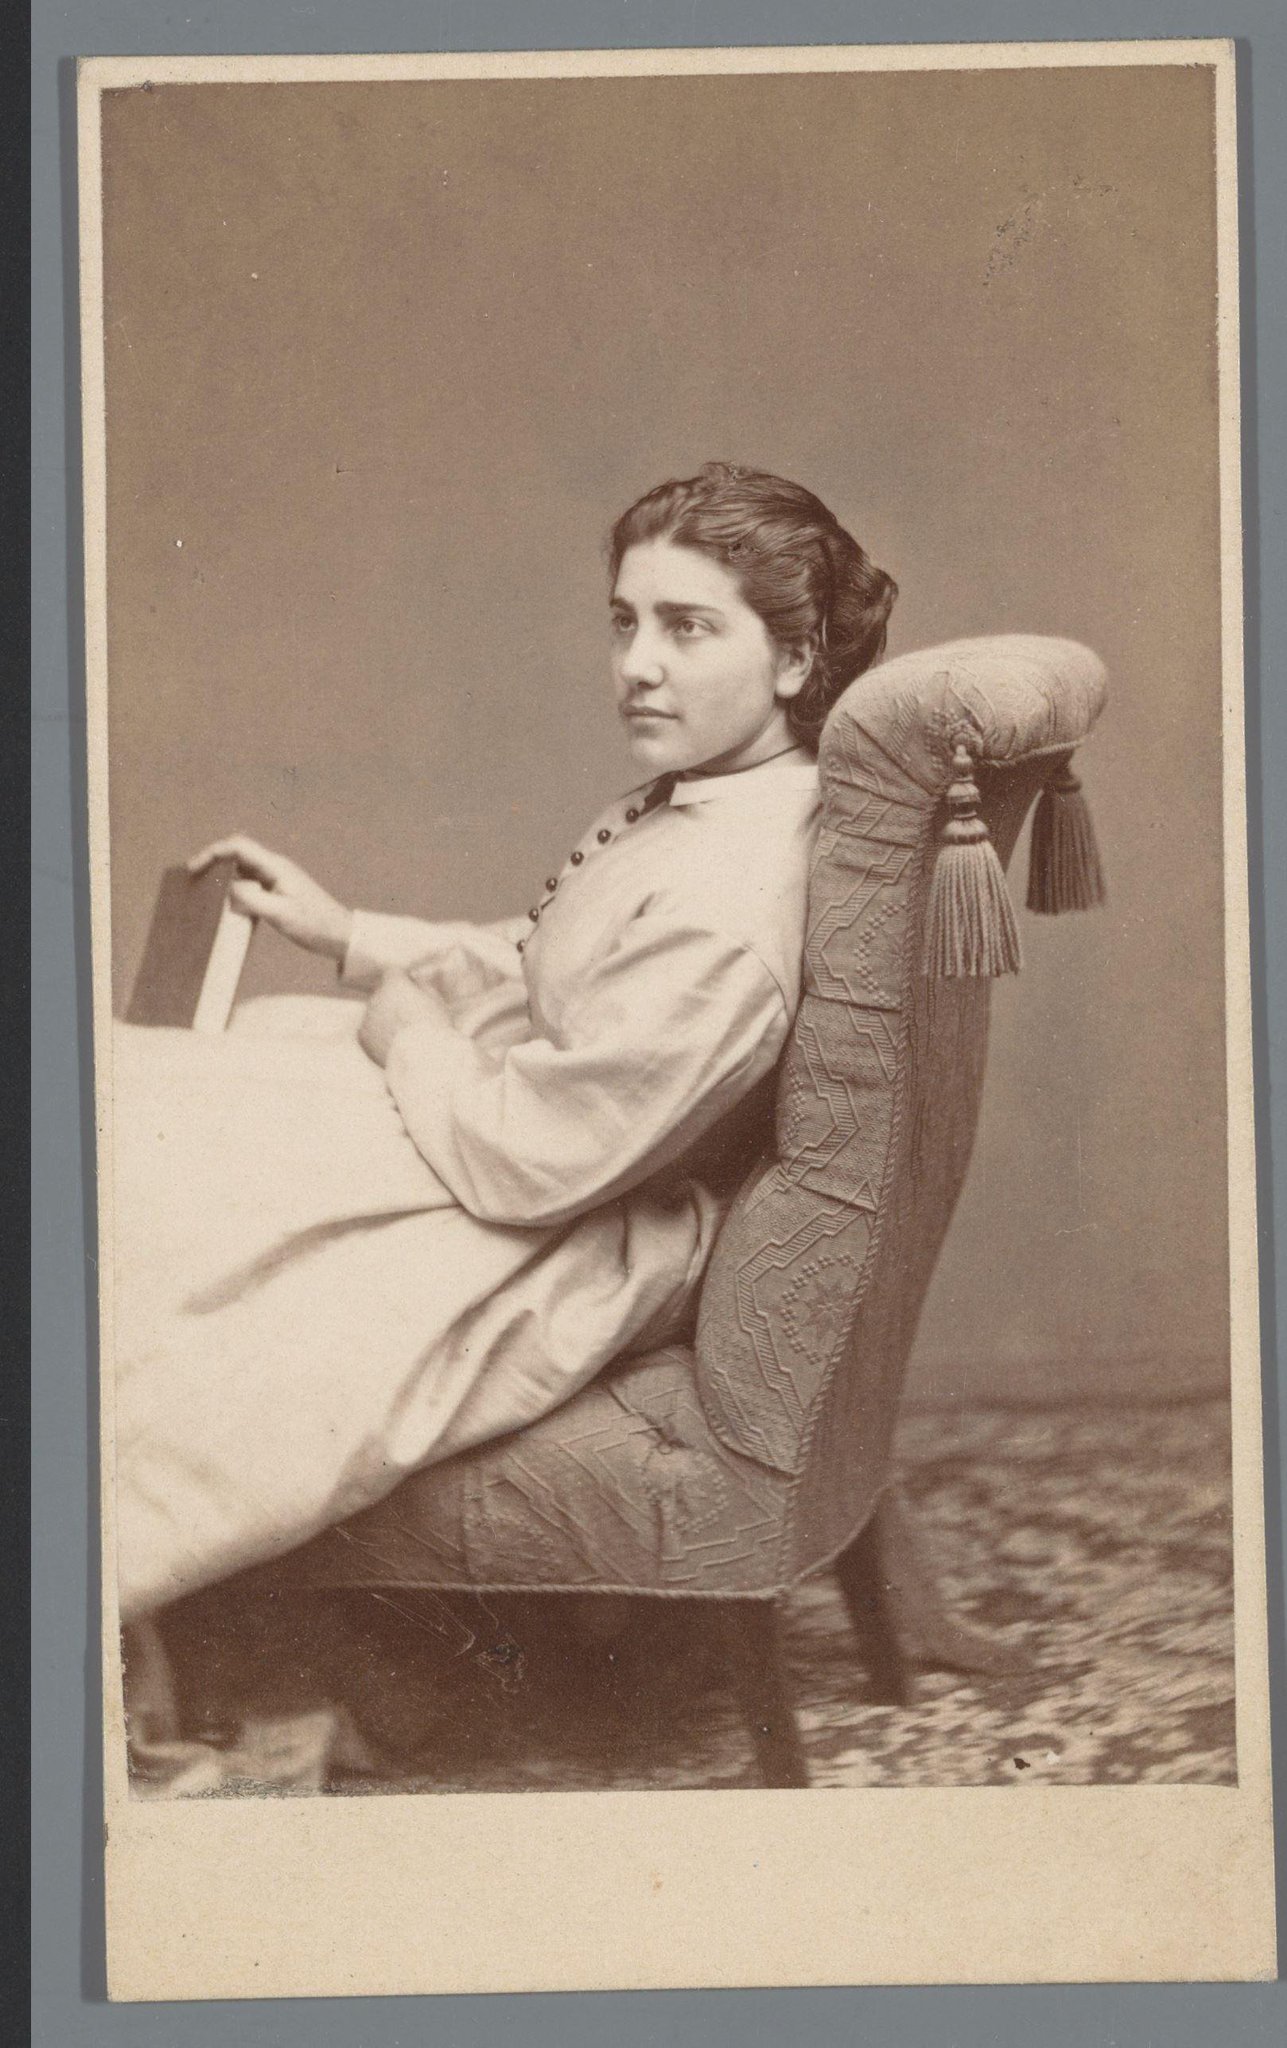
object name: photograph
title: Portret van een onbekende vrouw met boek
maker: jens petersen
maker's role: fotograaf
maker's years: 1829-1905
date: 1865-1875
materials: cardboard, paper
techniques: albumen print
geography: copenhagen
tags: adolescent, young woman, maiden, anonymous historical person portrayed, copenhagen (city)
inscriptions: inscription: ‘J. Petersen/ Kgl. Hof-Photograph/ Kongens Nytorv 3/ ved. Siden af Charlottenborg/ Kiöbenhavn.’